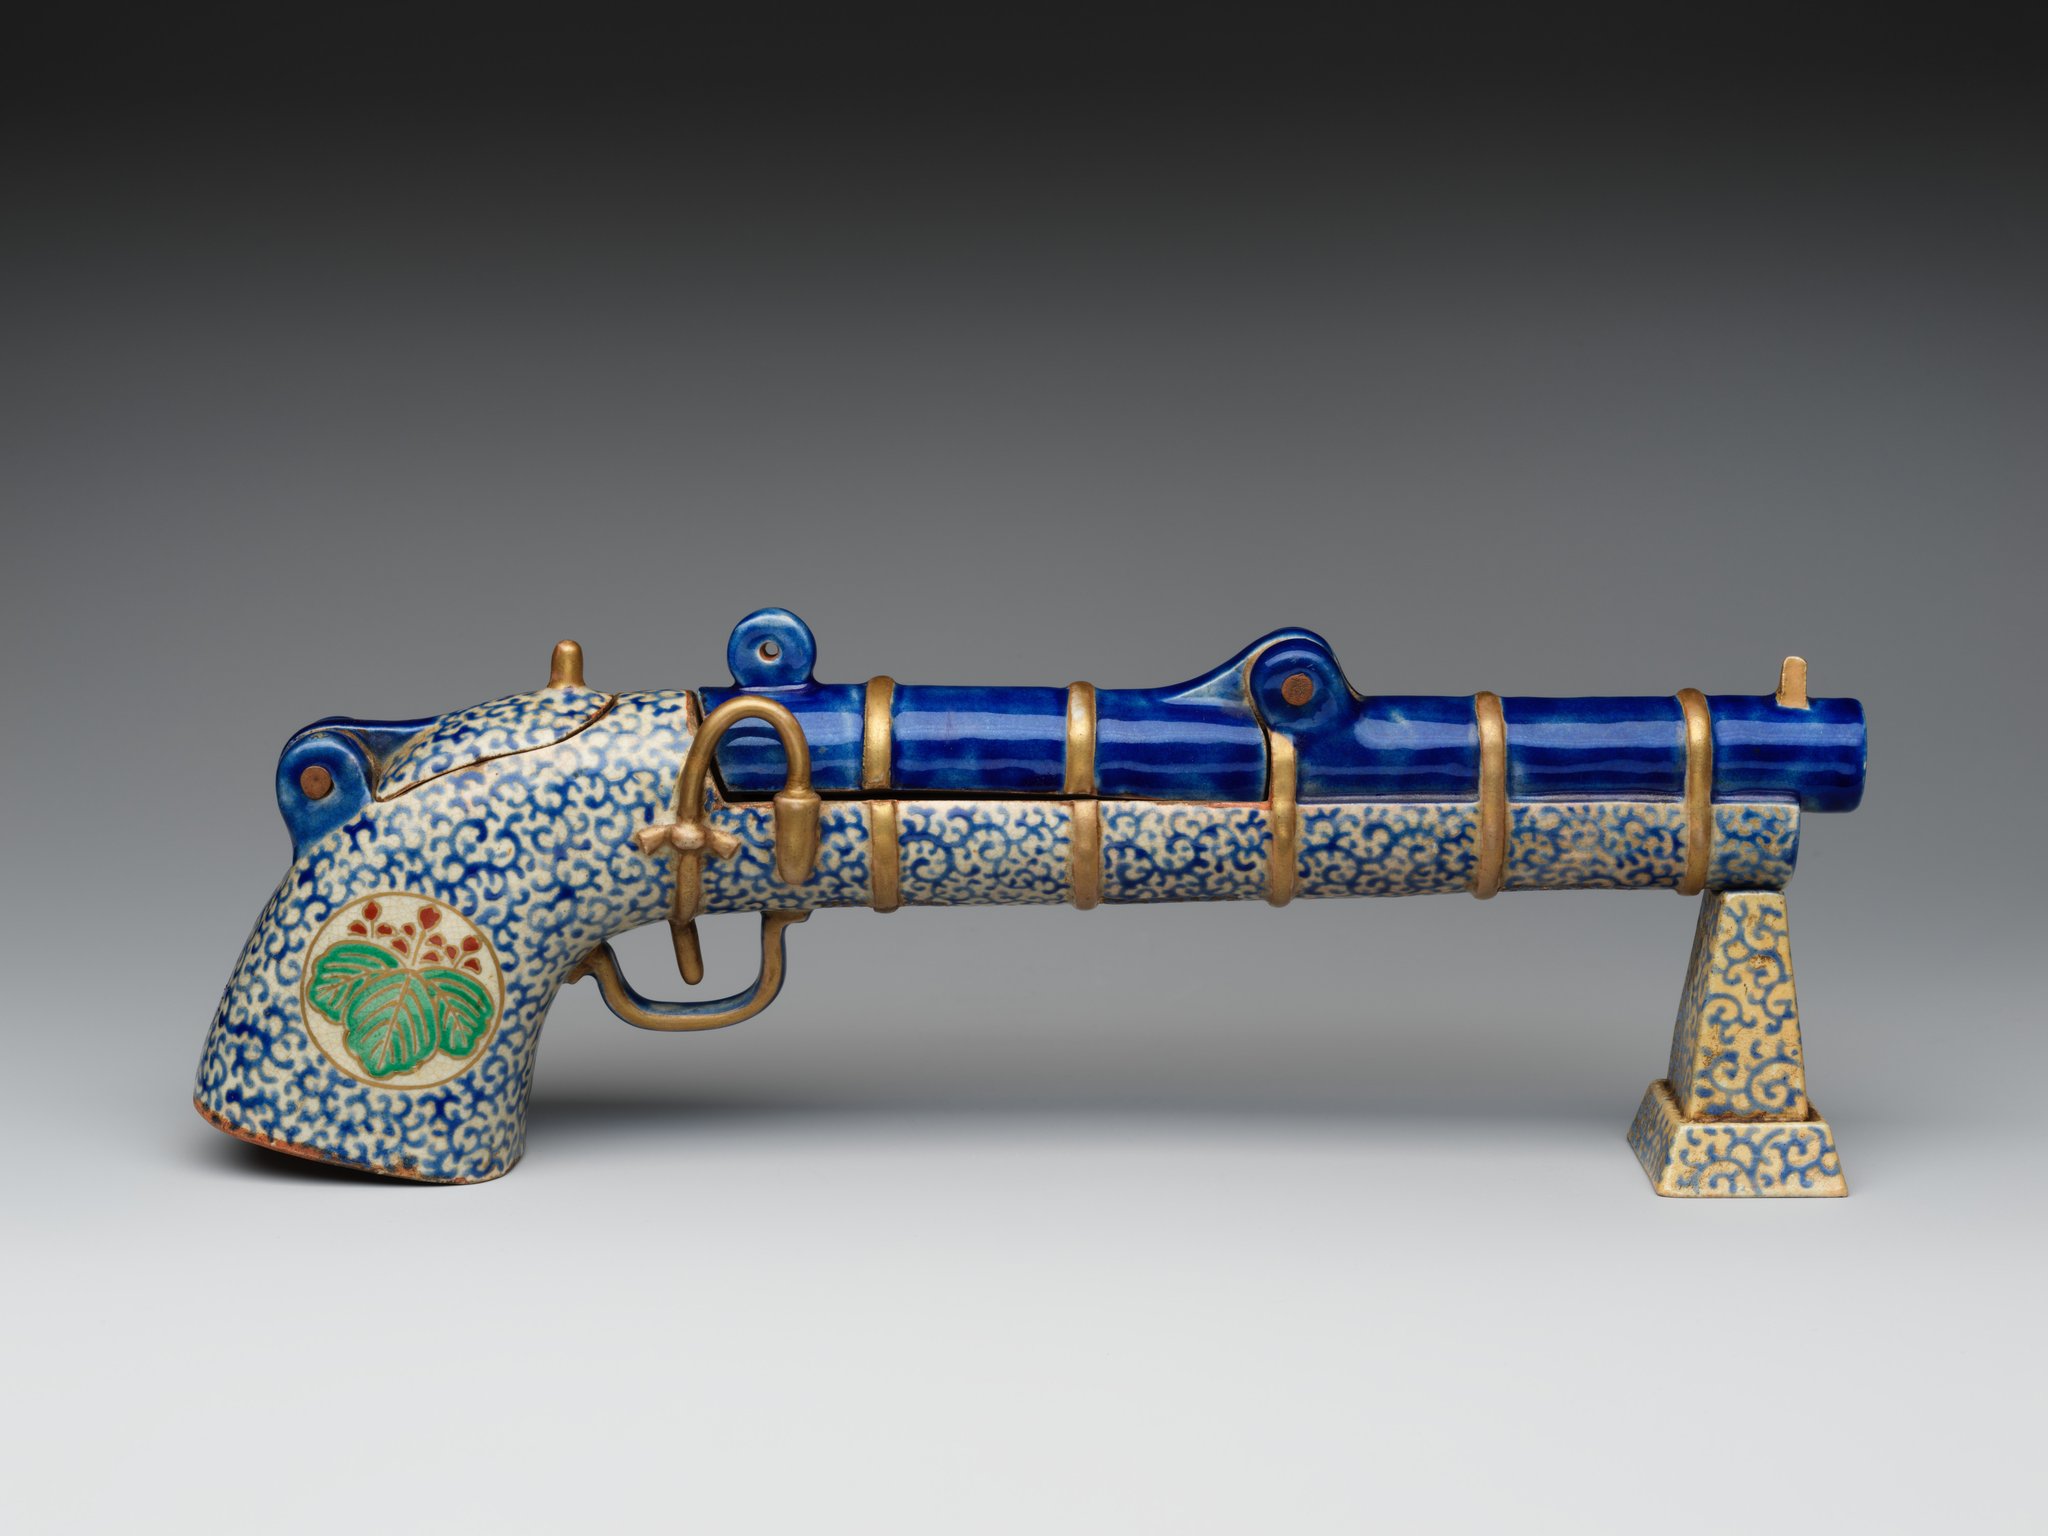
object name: incense burner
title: Incense burner in shape of a pistol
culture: japanese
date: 1615-1868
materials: earthenware, glaze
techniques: polychrome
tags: firearms